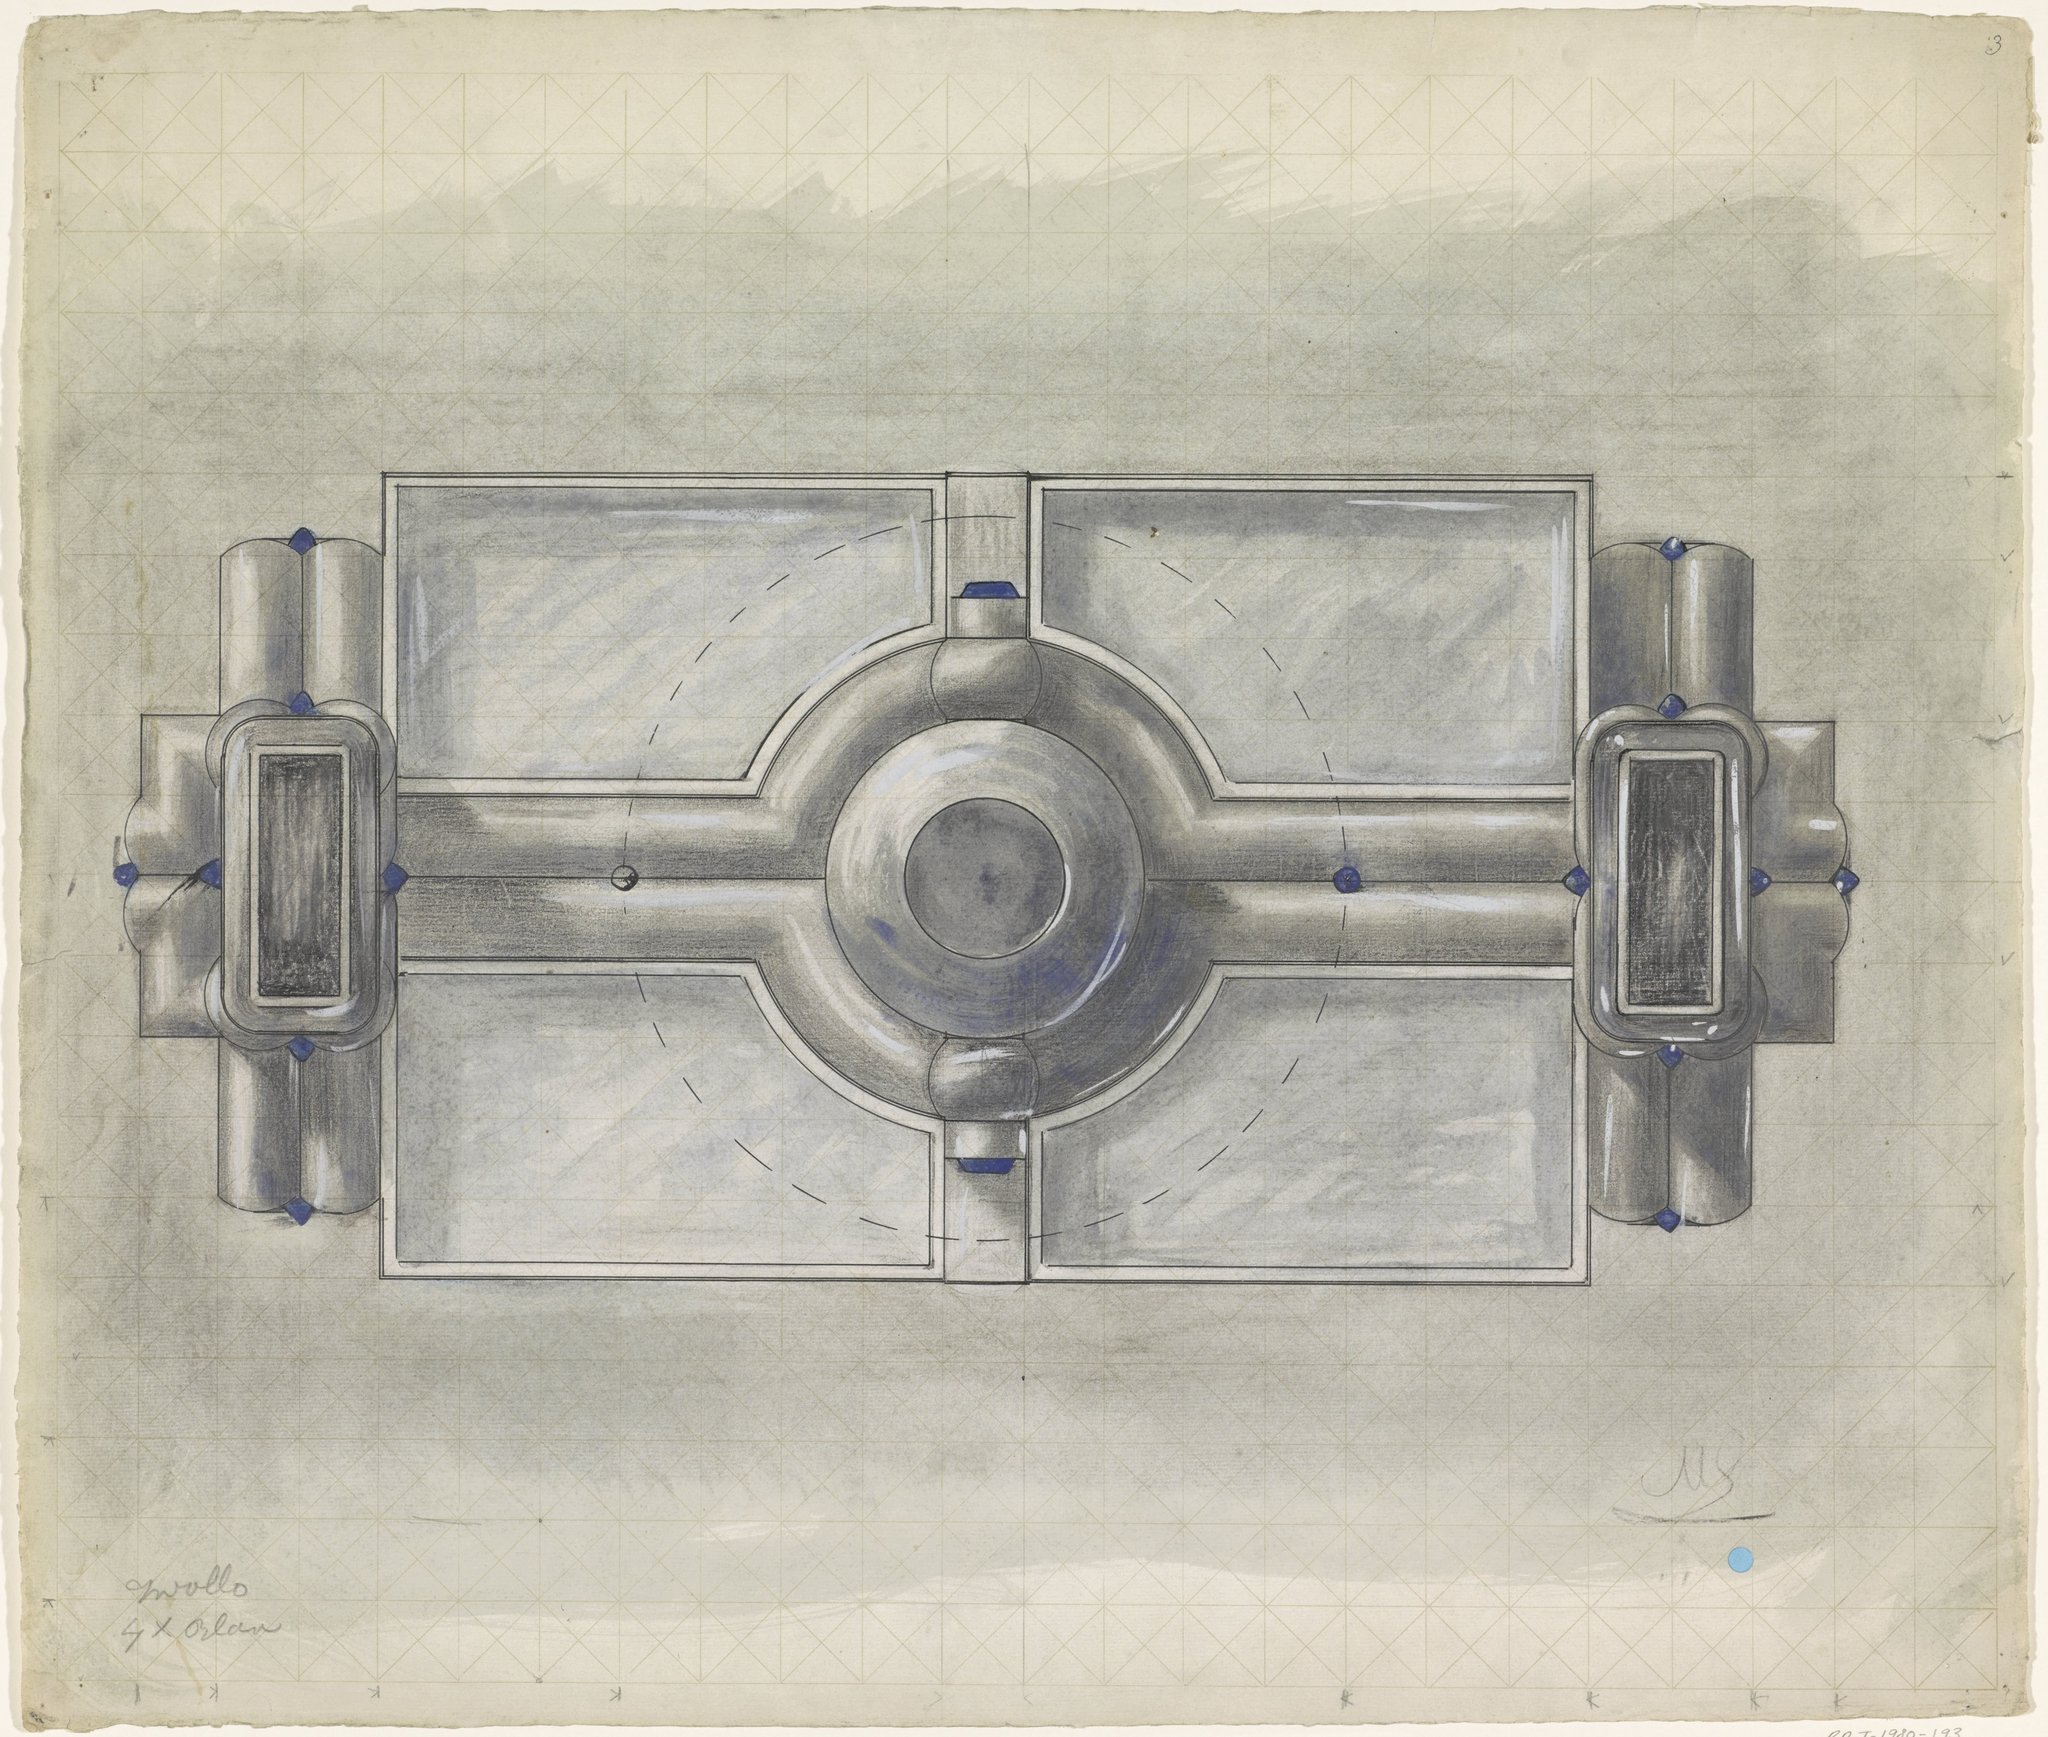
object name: design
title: Ontwerp voor een zilveren tafelstuk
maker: mathieu lauweriks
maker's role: designer, draughtsman, print maker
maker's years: 1864-1932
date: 1874-1932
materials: chalk, ink, paper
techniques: brush, pen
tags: centre-piece, epergne, 'surtout', 'milieu-de-table', work of applied art (+ precious metals ~ arts)